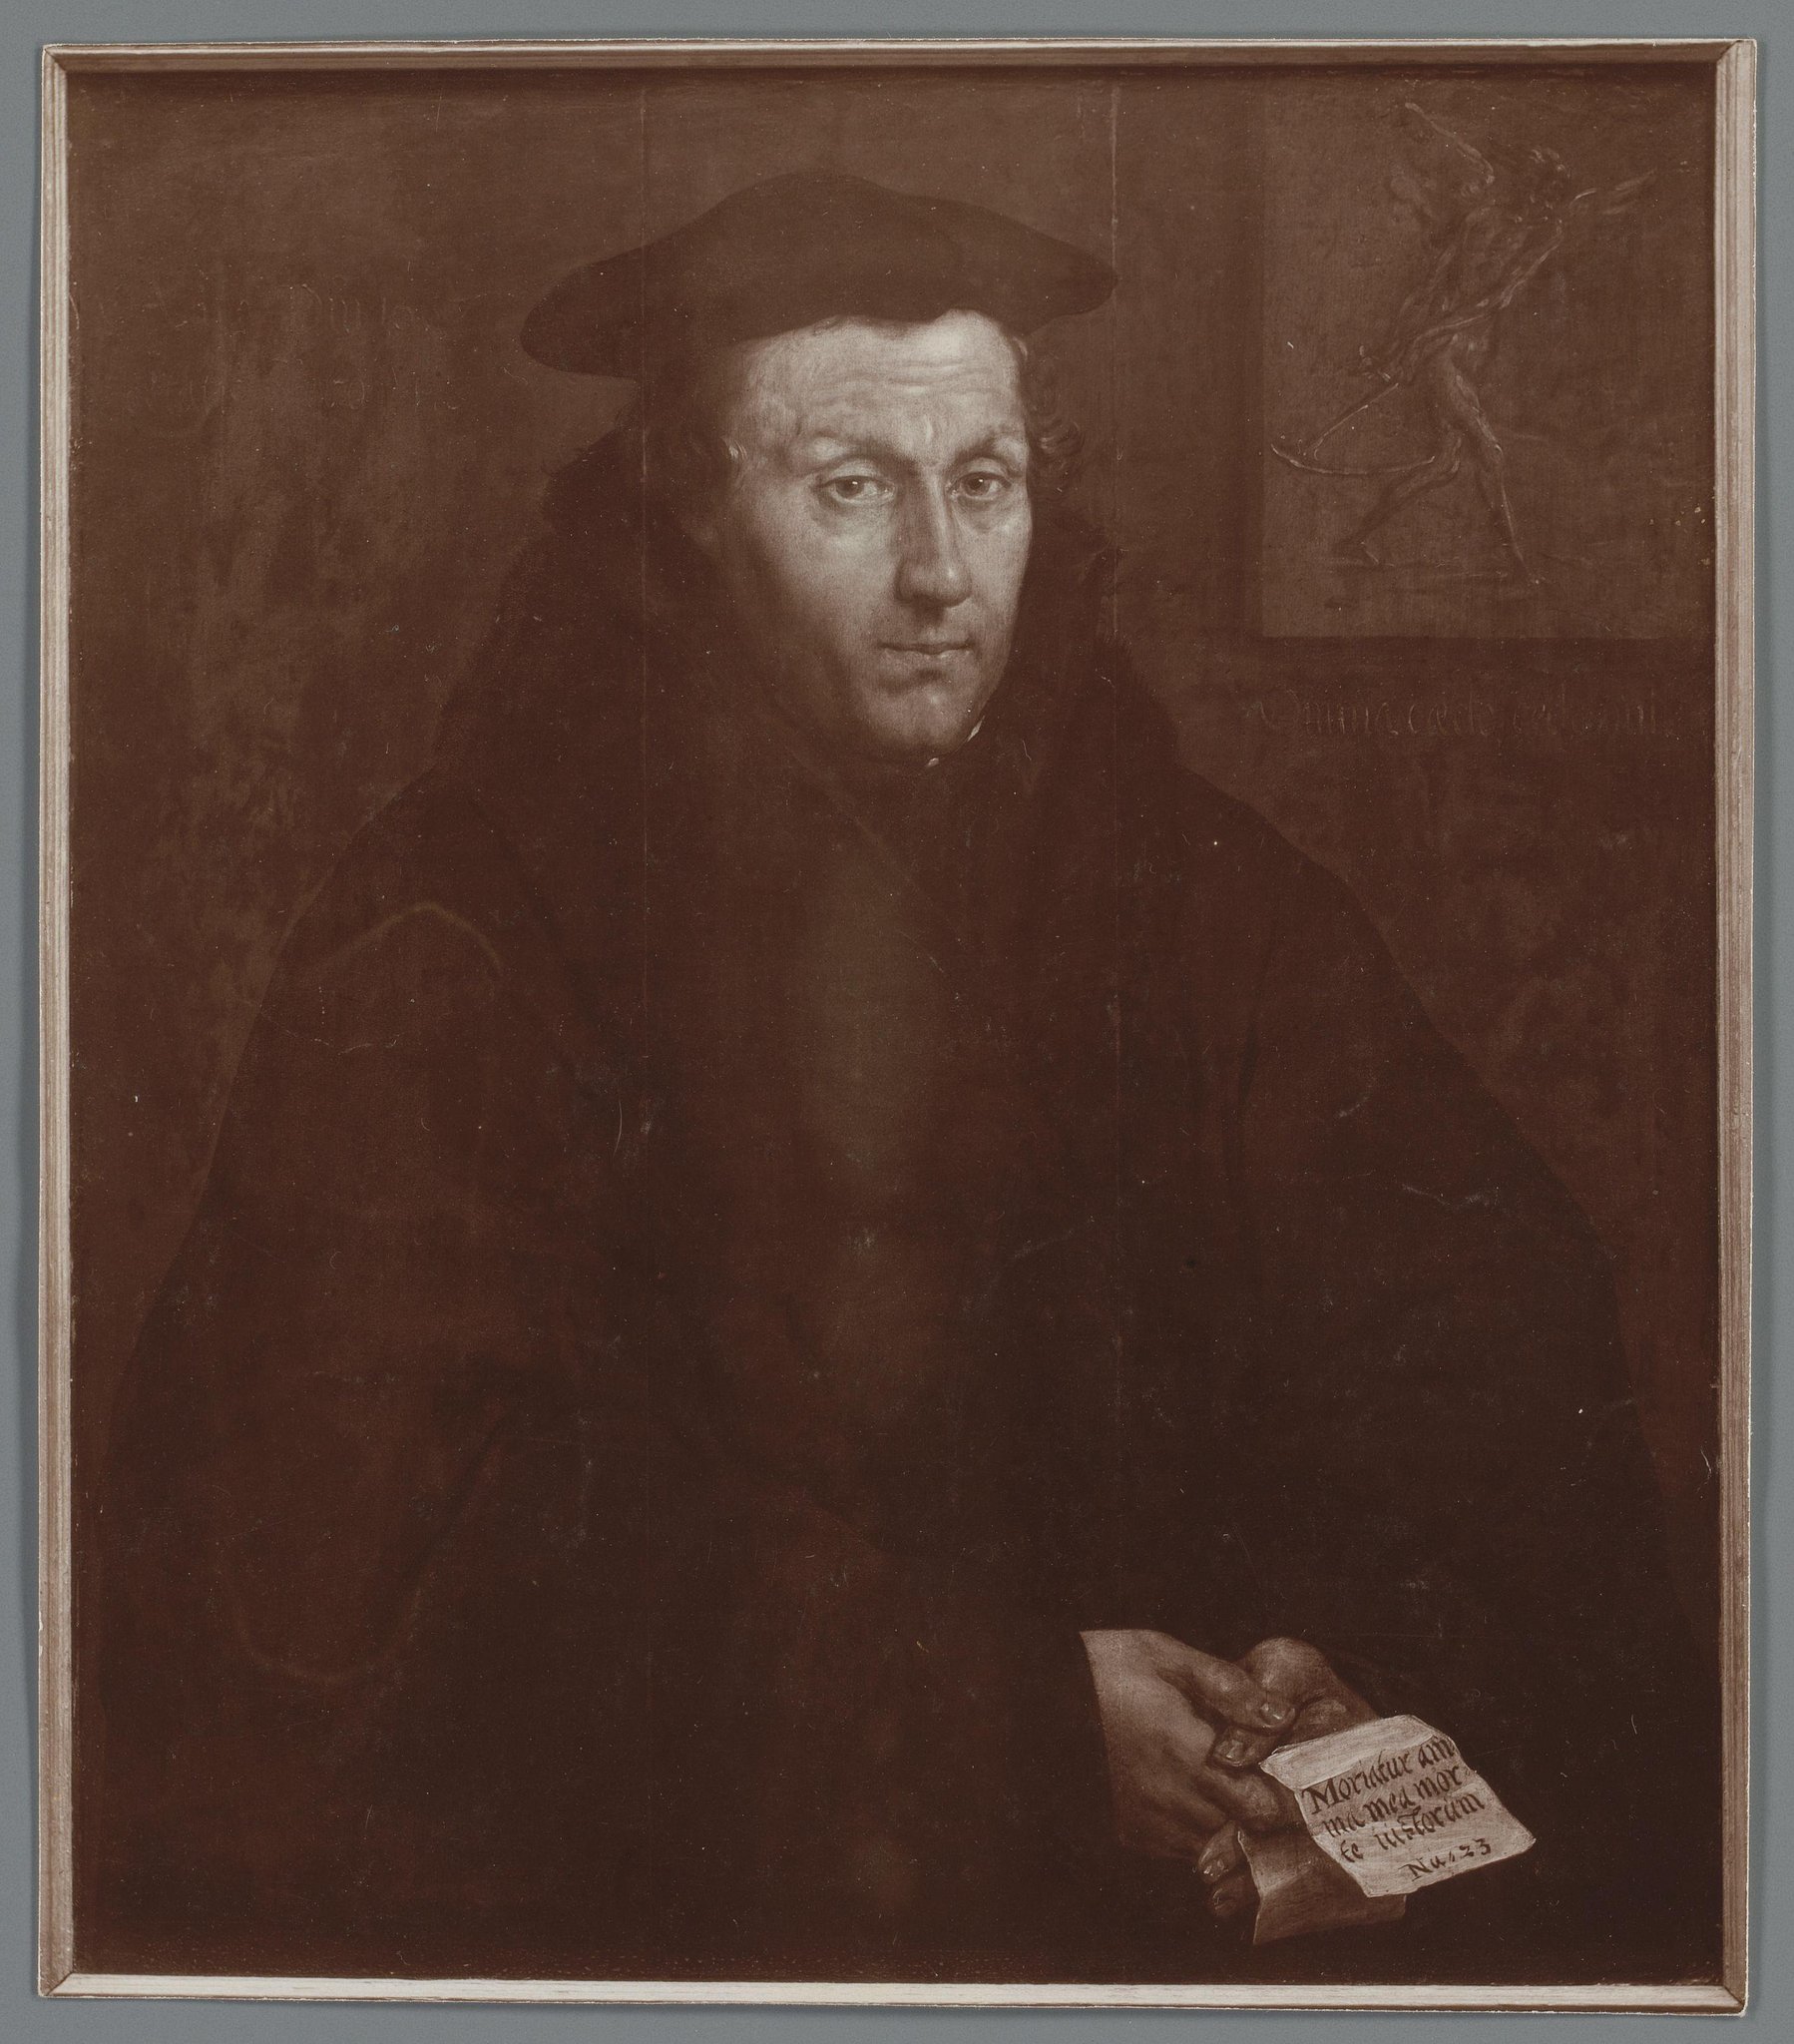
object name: photograph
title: Fotoreproductie van een geschilderd portret van burgemeester Jan Hendricksz.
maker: Anonymous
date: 1890-1920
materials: paper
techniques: gelatin silver print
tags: mayor, historical persons, board, esp. governors, trustees, etc. (dutch: 'regenten')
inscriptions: number: ‘2’, inscription: ‘I Dieter Barentsz/ Bürgermeister Dirik Jan Hendricksz/ "Otto's Hofje", Amsterdam/ No 69’